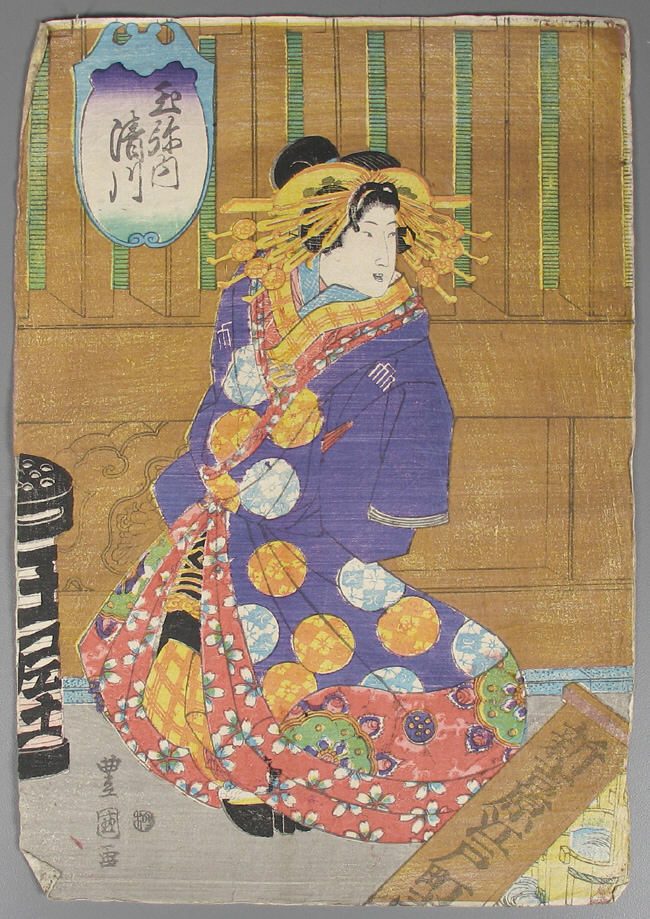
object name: print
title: Bundle of Prints (Untitled)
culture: japanese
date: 1800-1899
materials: ink, paper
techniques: woodblock print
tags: women